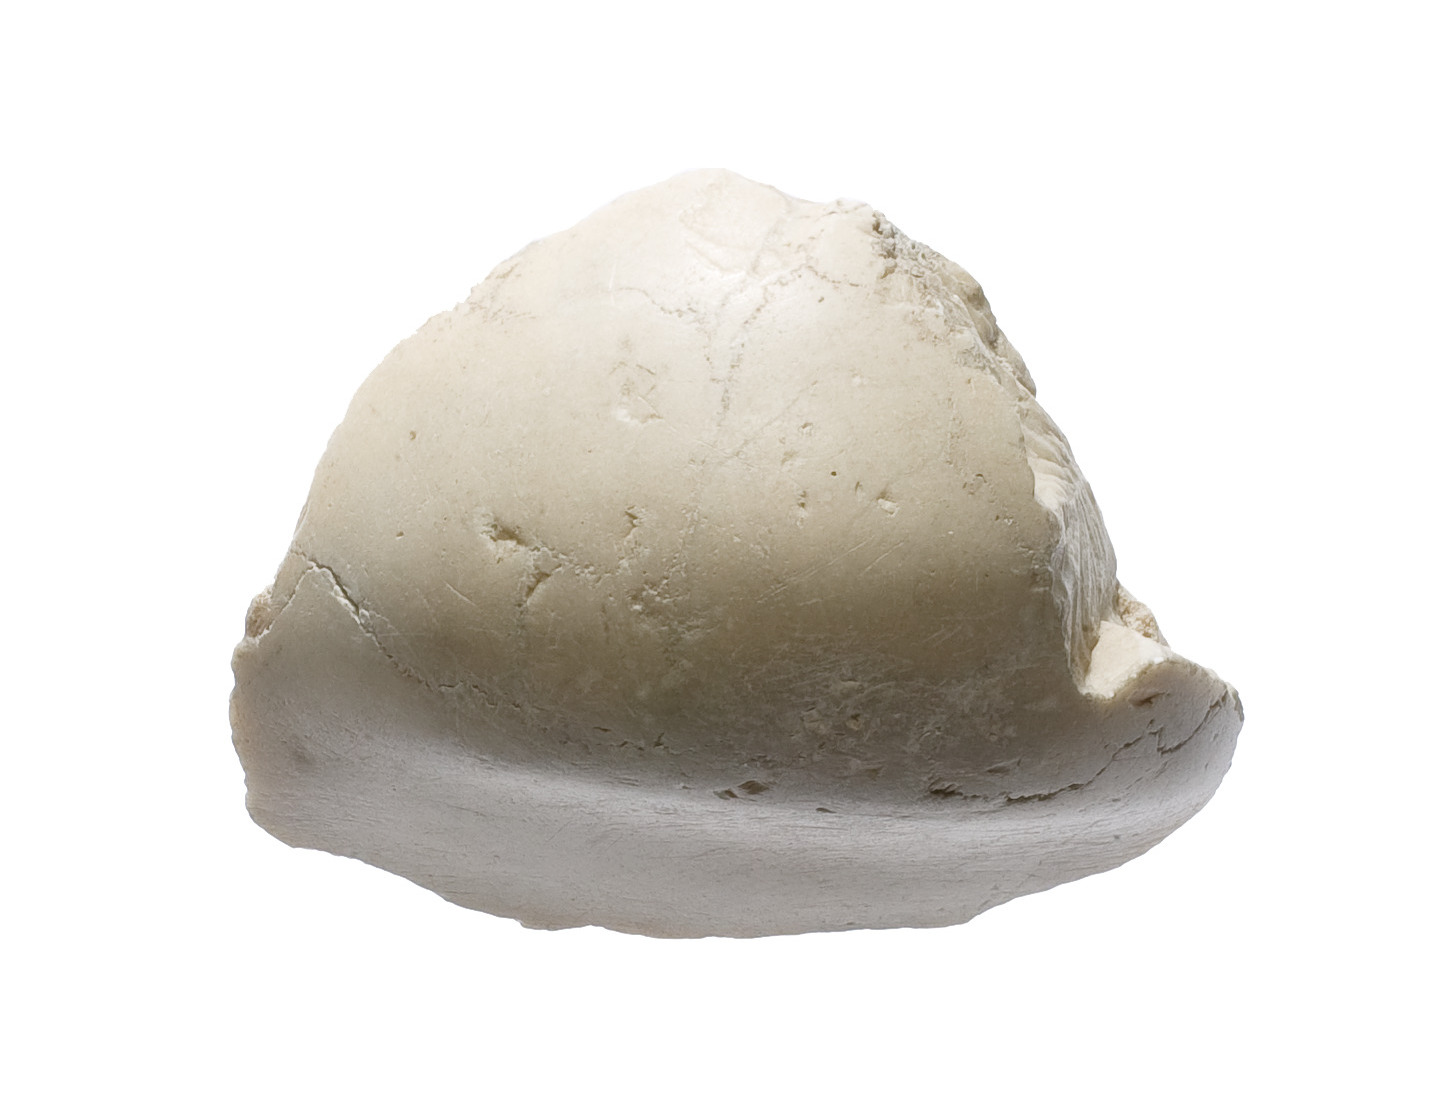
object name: head fragment, chin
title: Chin (?) from a head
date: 1353-1336 BCE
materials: limestone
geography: egypt